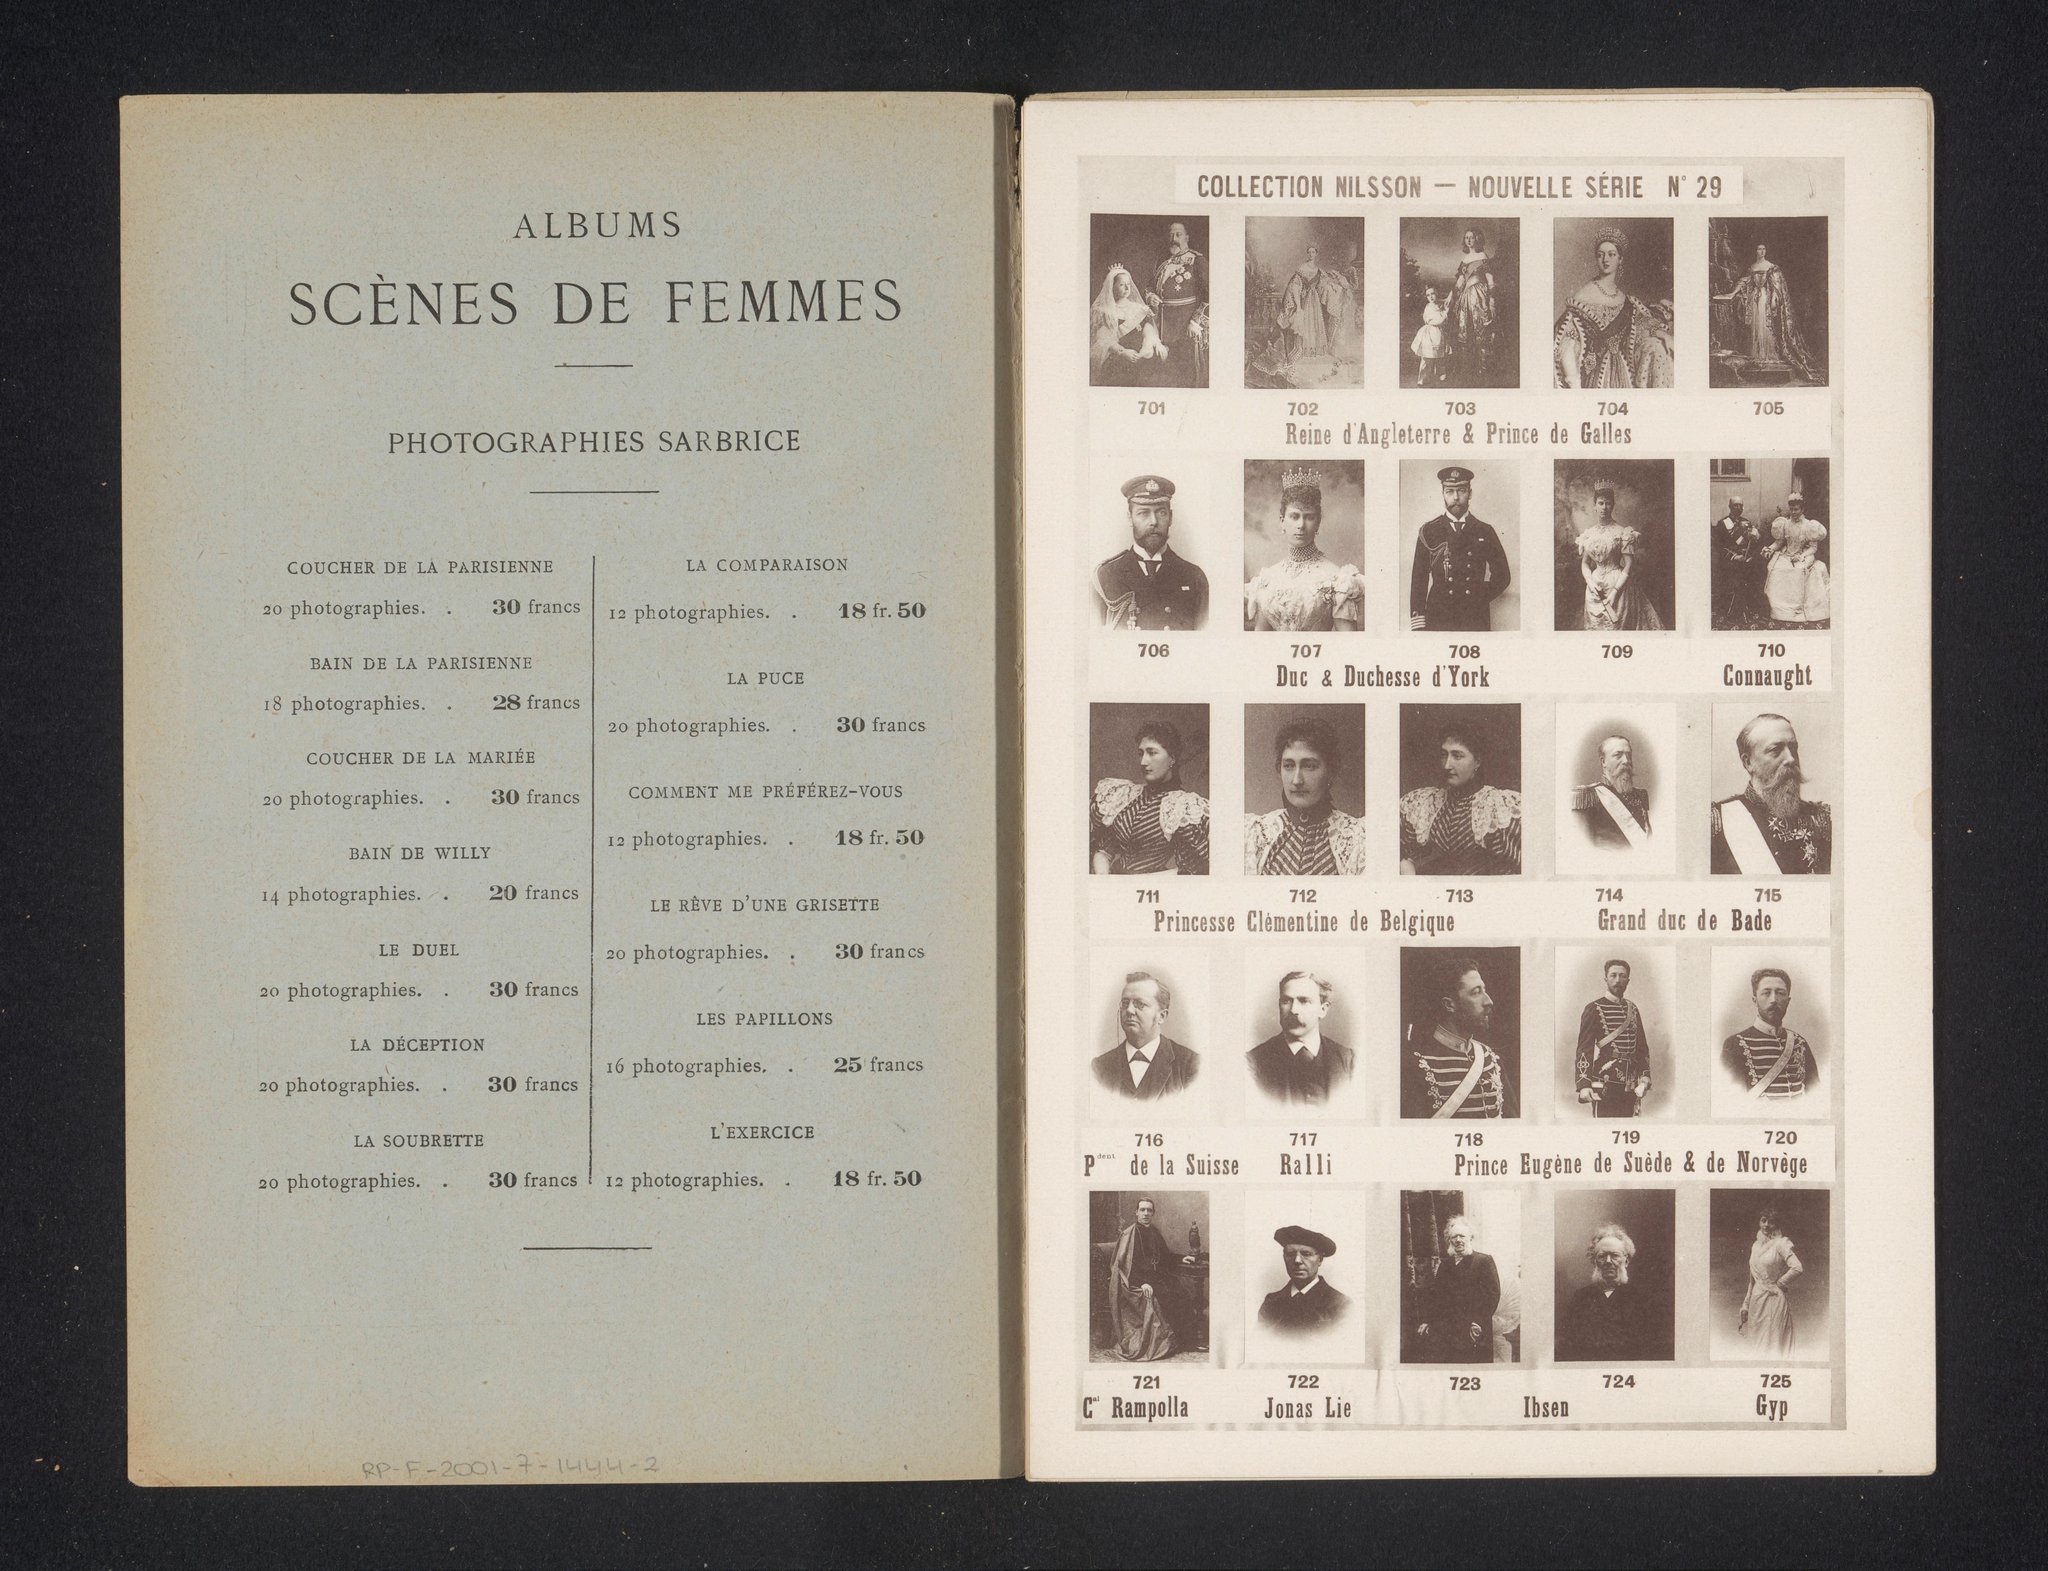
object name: page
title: 25 portretten van George V van Engeland, reproducties van schilderijen van portretten van koningin Victoria van Engeland, Clementine van België, Frederik I van Baden, Eugenius van Zweden en anderen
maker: Anonymous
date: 1892-1897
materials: paper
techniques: photograph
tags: victoria (koningin van het verenigd koninkrijk en keizerin van india), laeken, historical persons - bb - woman, historical persons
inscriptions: number: ‘No 29’